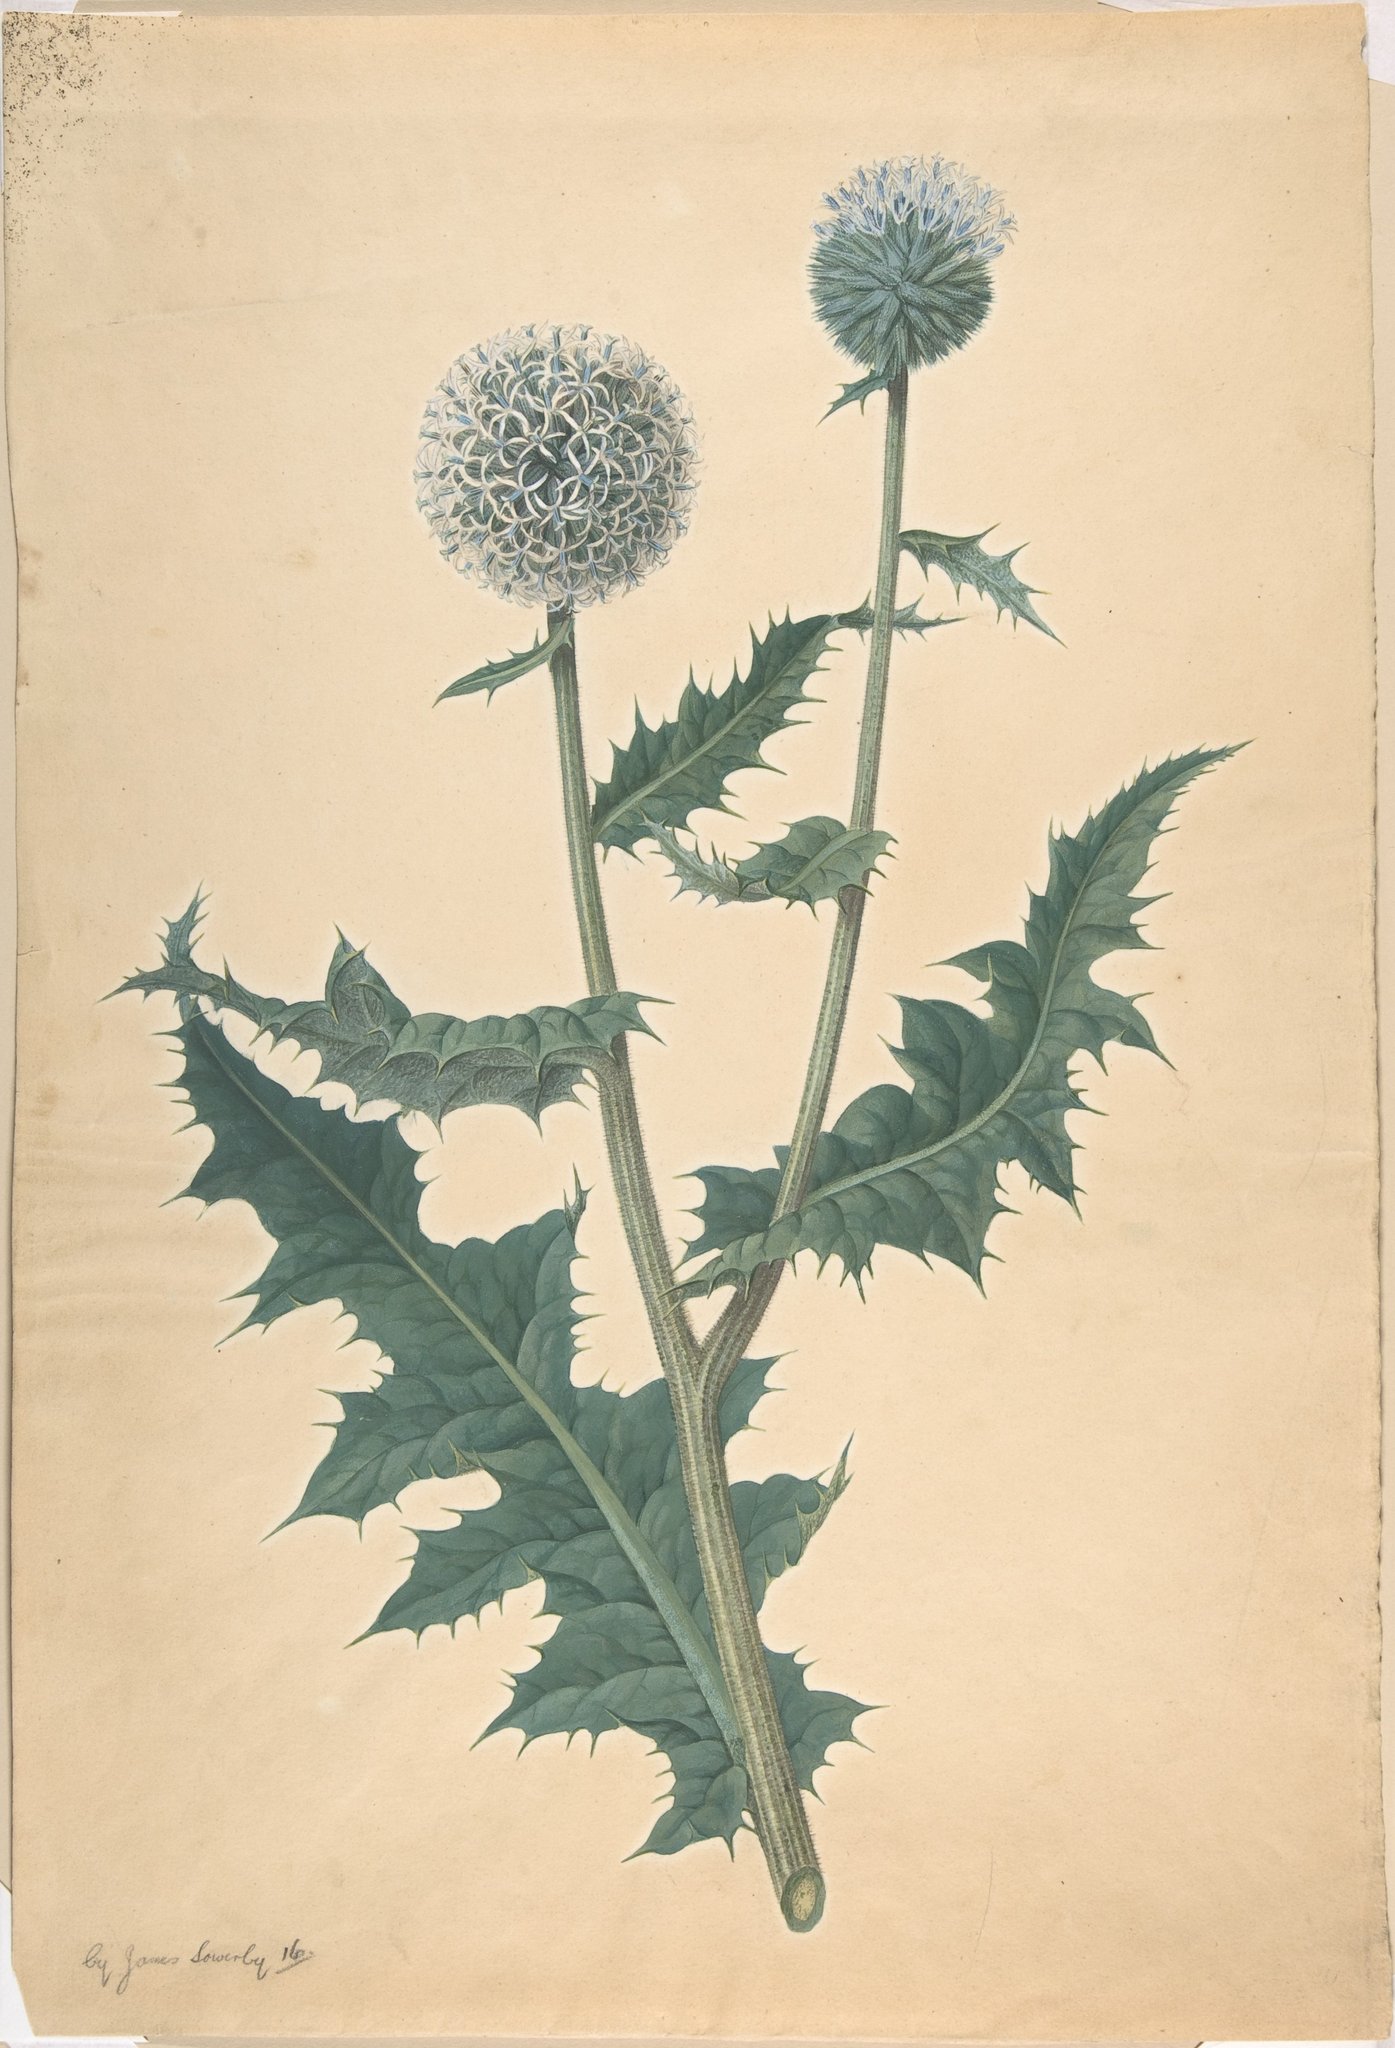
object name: drawing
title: Study of a thistle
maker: james sowerby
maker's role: artist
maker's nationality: british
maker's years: 1757-1822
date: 1822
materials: gouache, graphite, paper, watercolor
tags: flowers,leaves